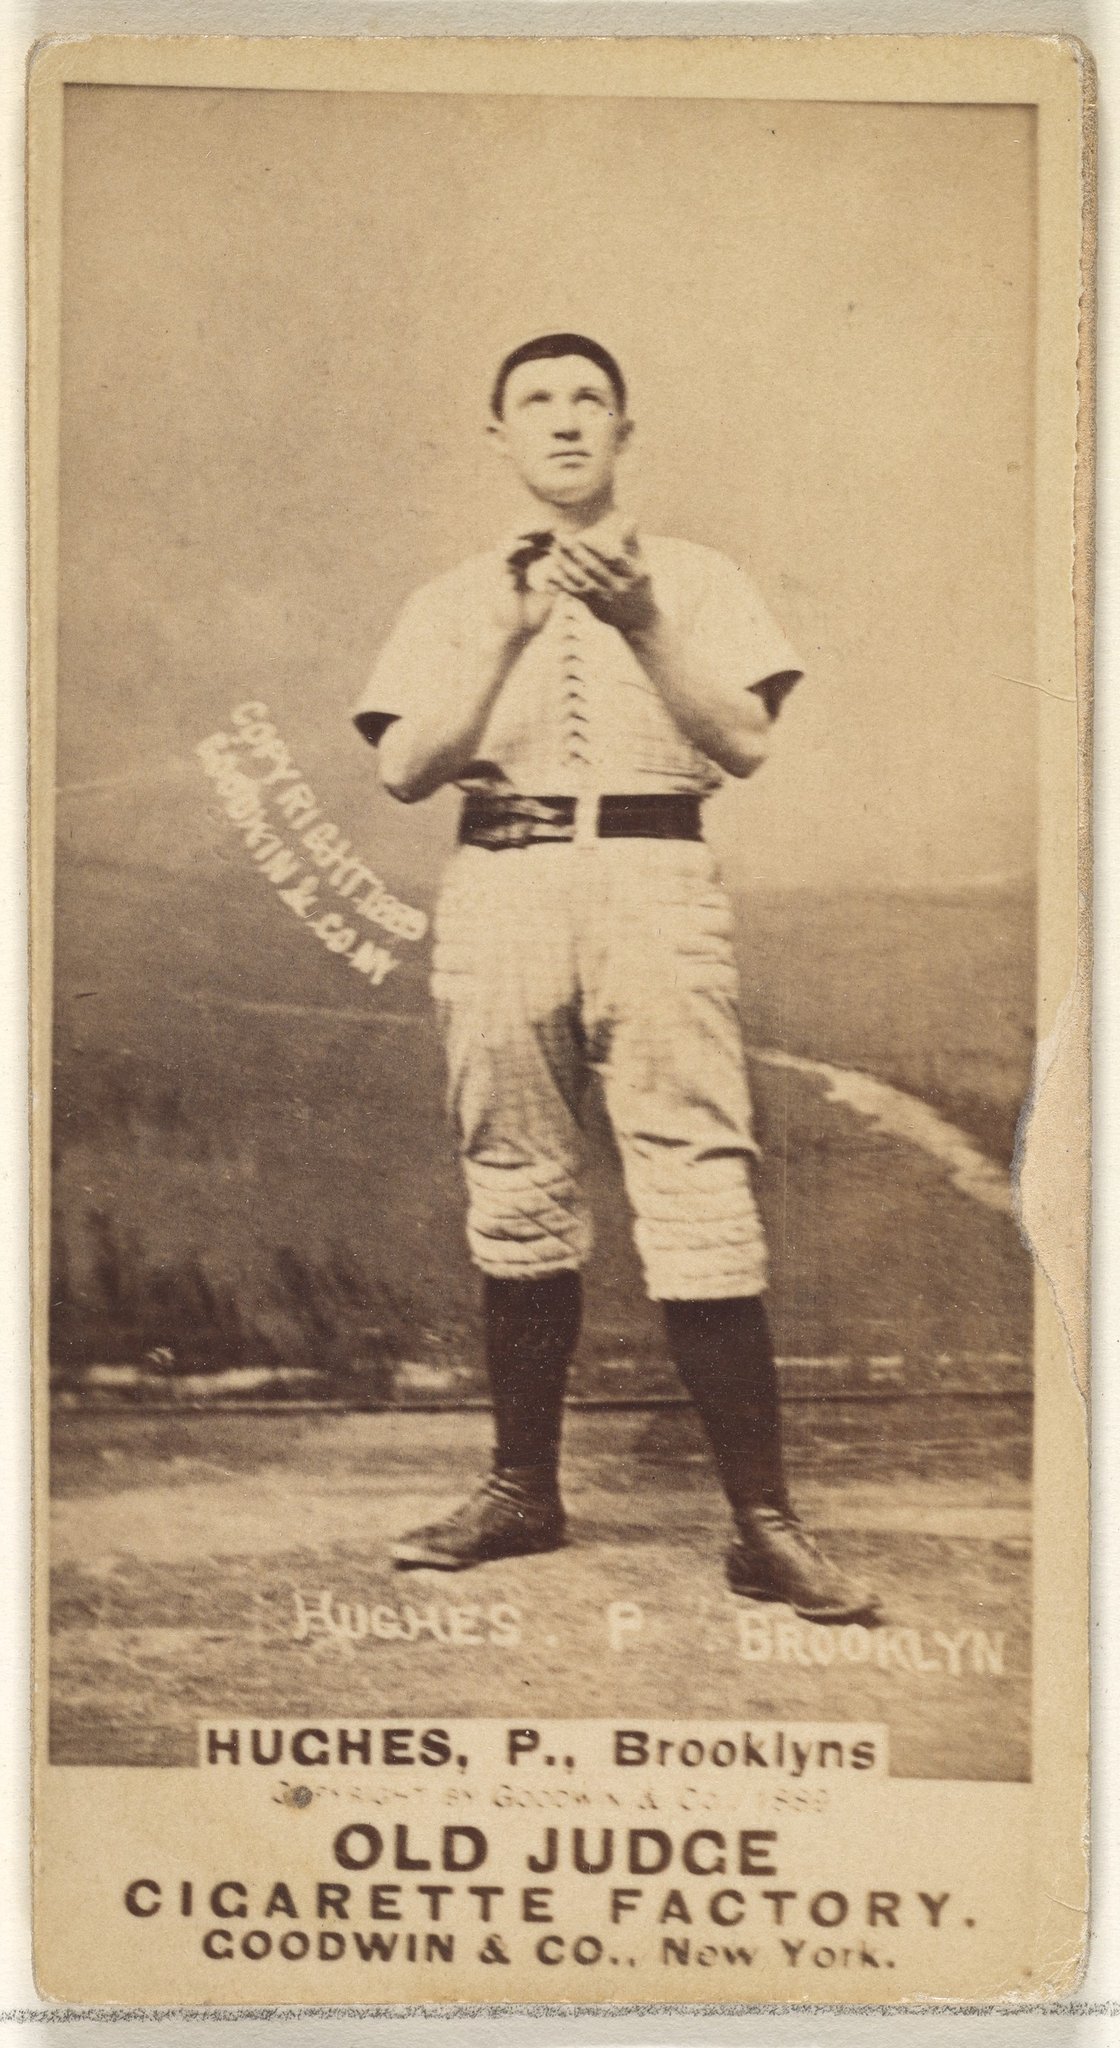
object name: baseball card, photograph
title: Hughes, Pitcher, Brooklyn Bridegrooms, from the Old Judge series (N172) for Old Judge Cigarettes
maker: goodwin & company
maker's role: publisher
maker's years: 1850-1950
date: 1889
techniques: albumen silver print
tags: men,portraits,baseball,athletes